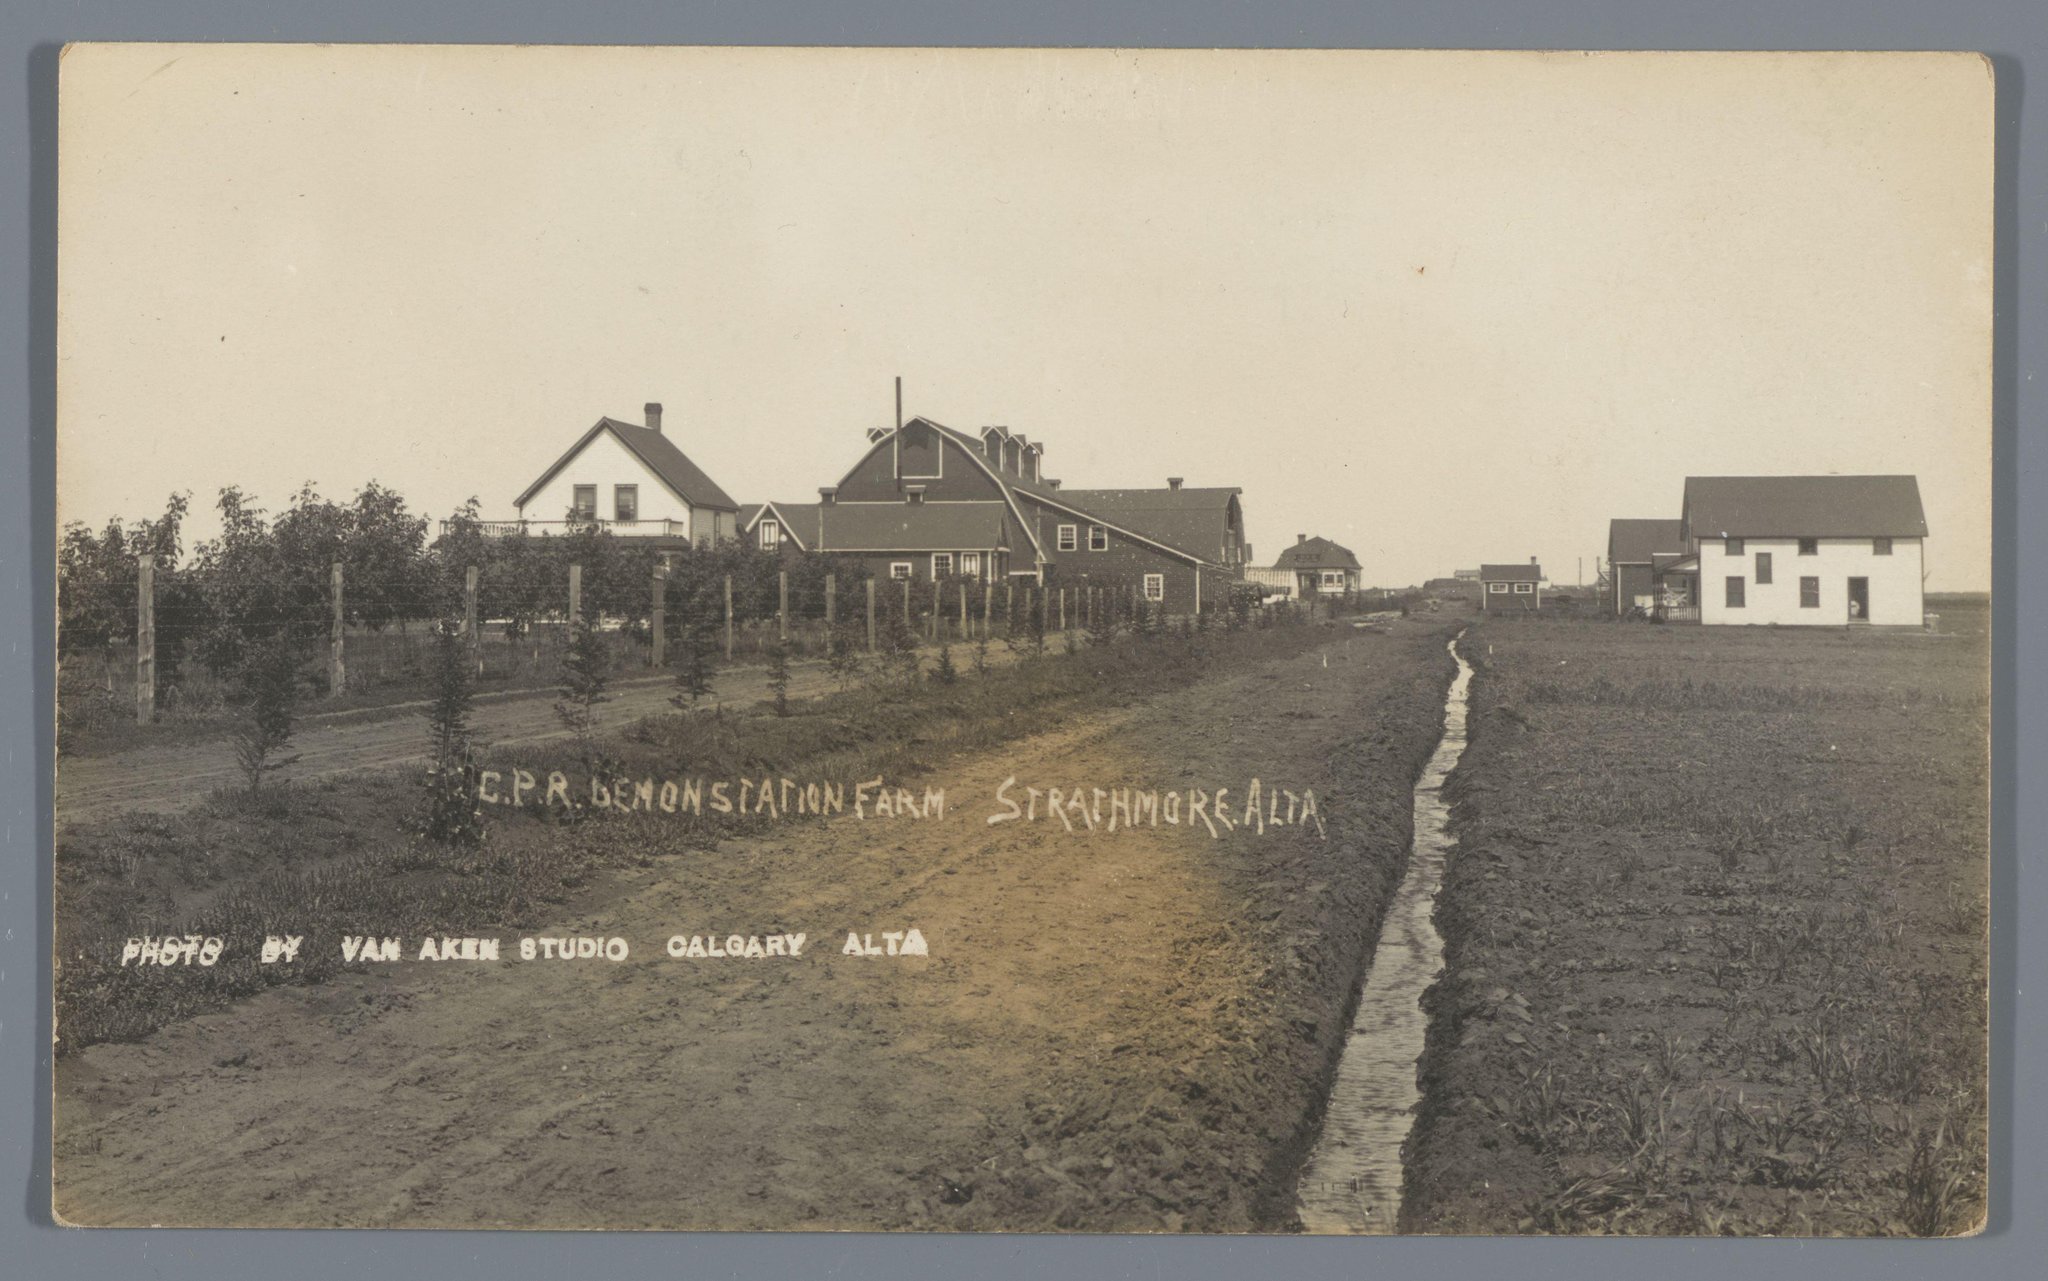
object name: ansichtkaart, prentbriefkaart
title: Gezicht op C.P.R. Demonstration Farm, Strathmore, Altona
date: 1900-1920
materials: photographic support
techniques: gelatin silver print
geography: calgary